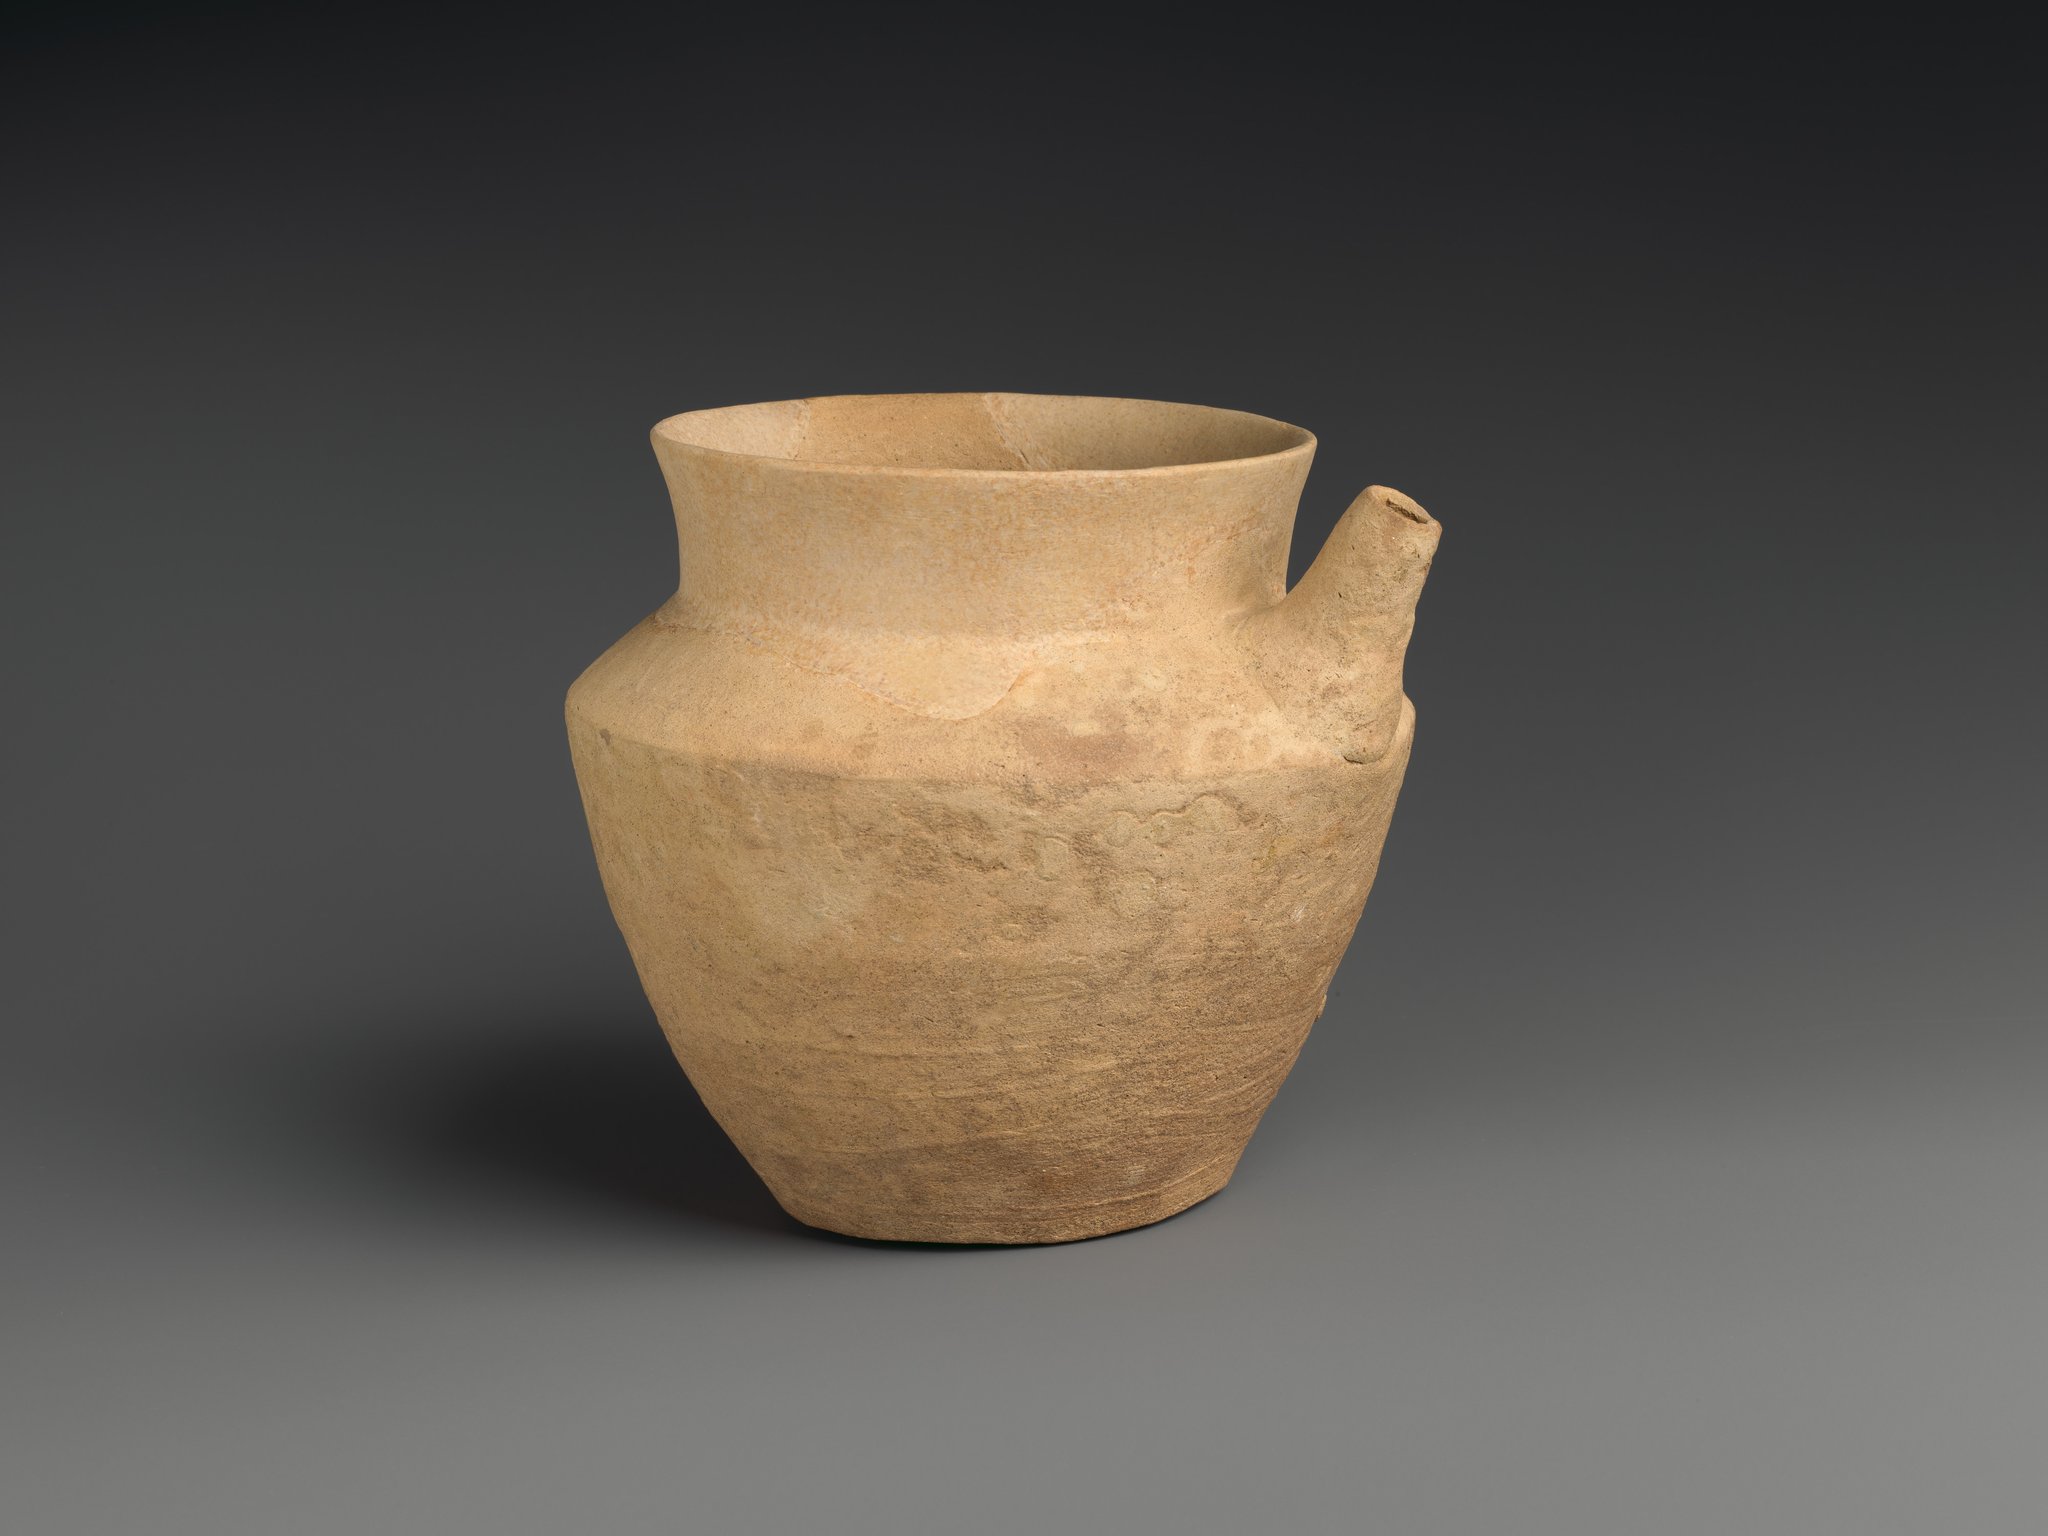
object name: jar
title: Spouted jar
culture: sumerian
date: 2900-2700 BCE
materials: ceramic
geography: mesopotamia